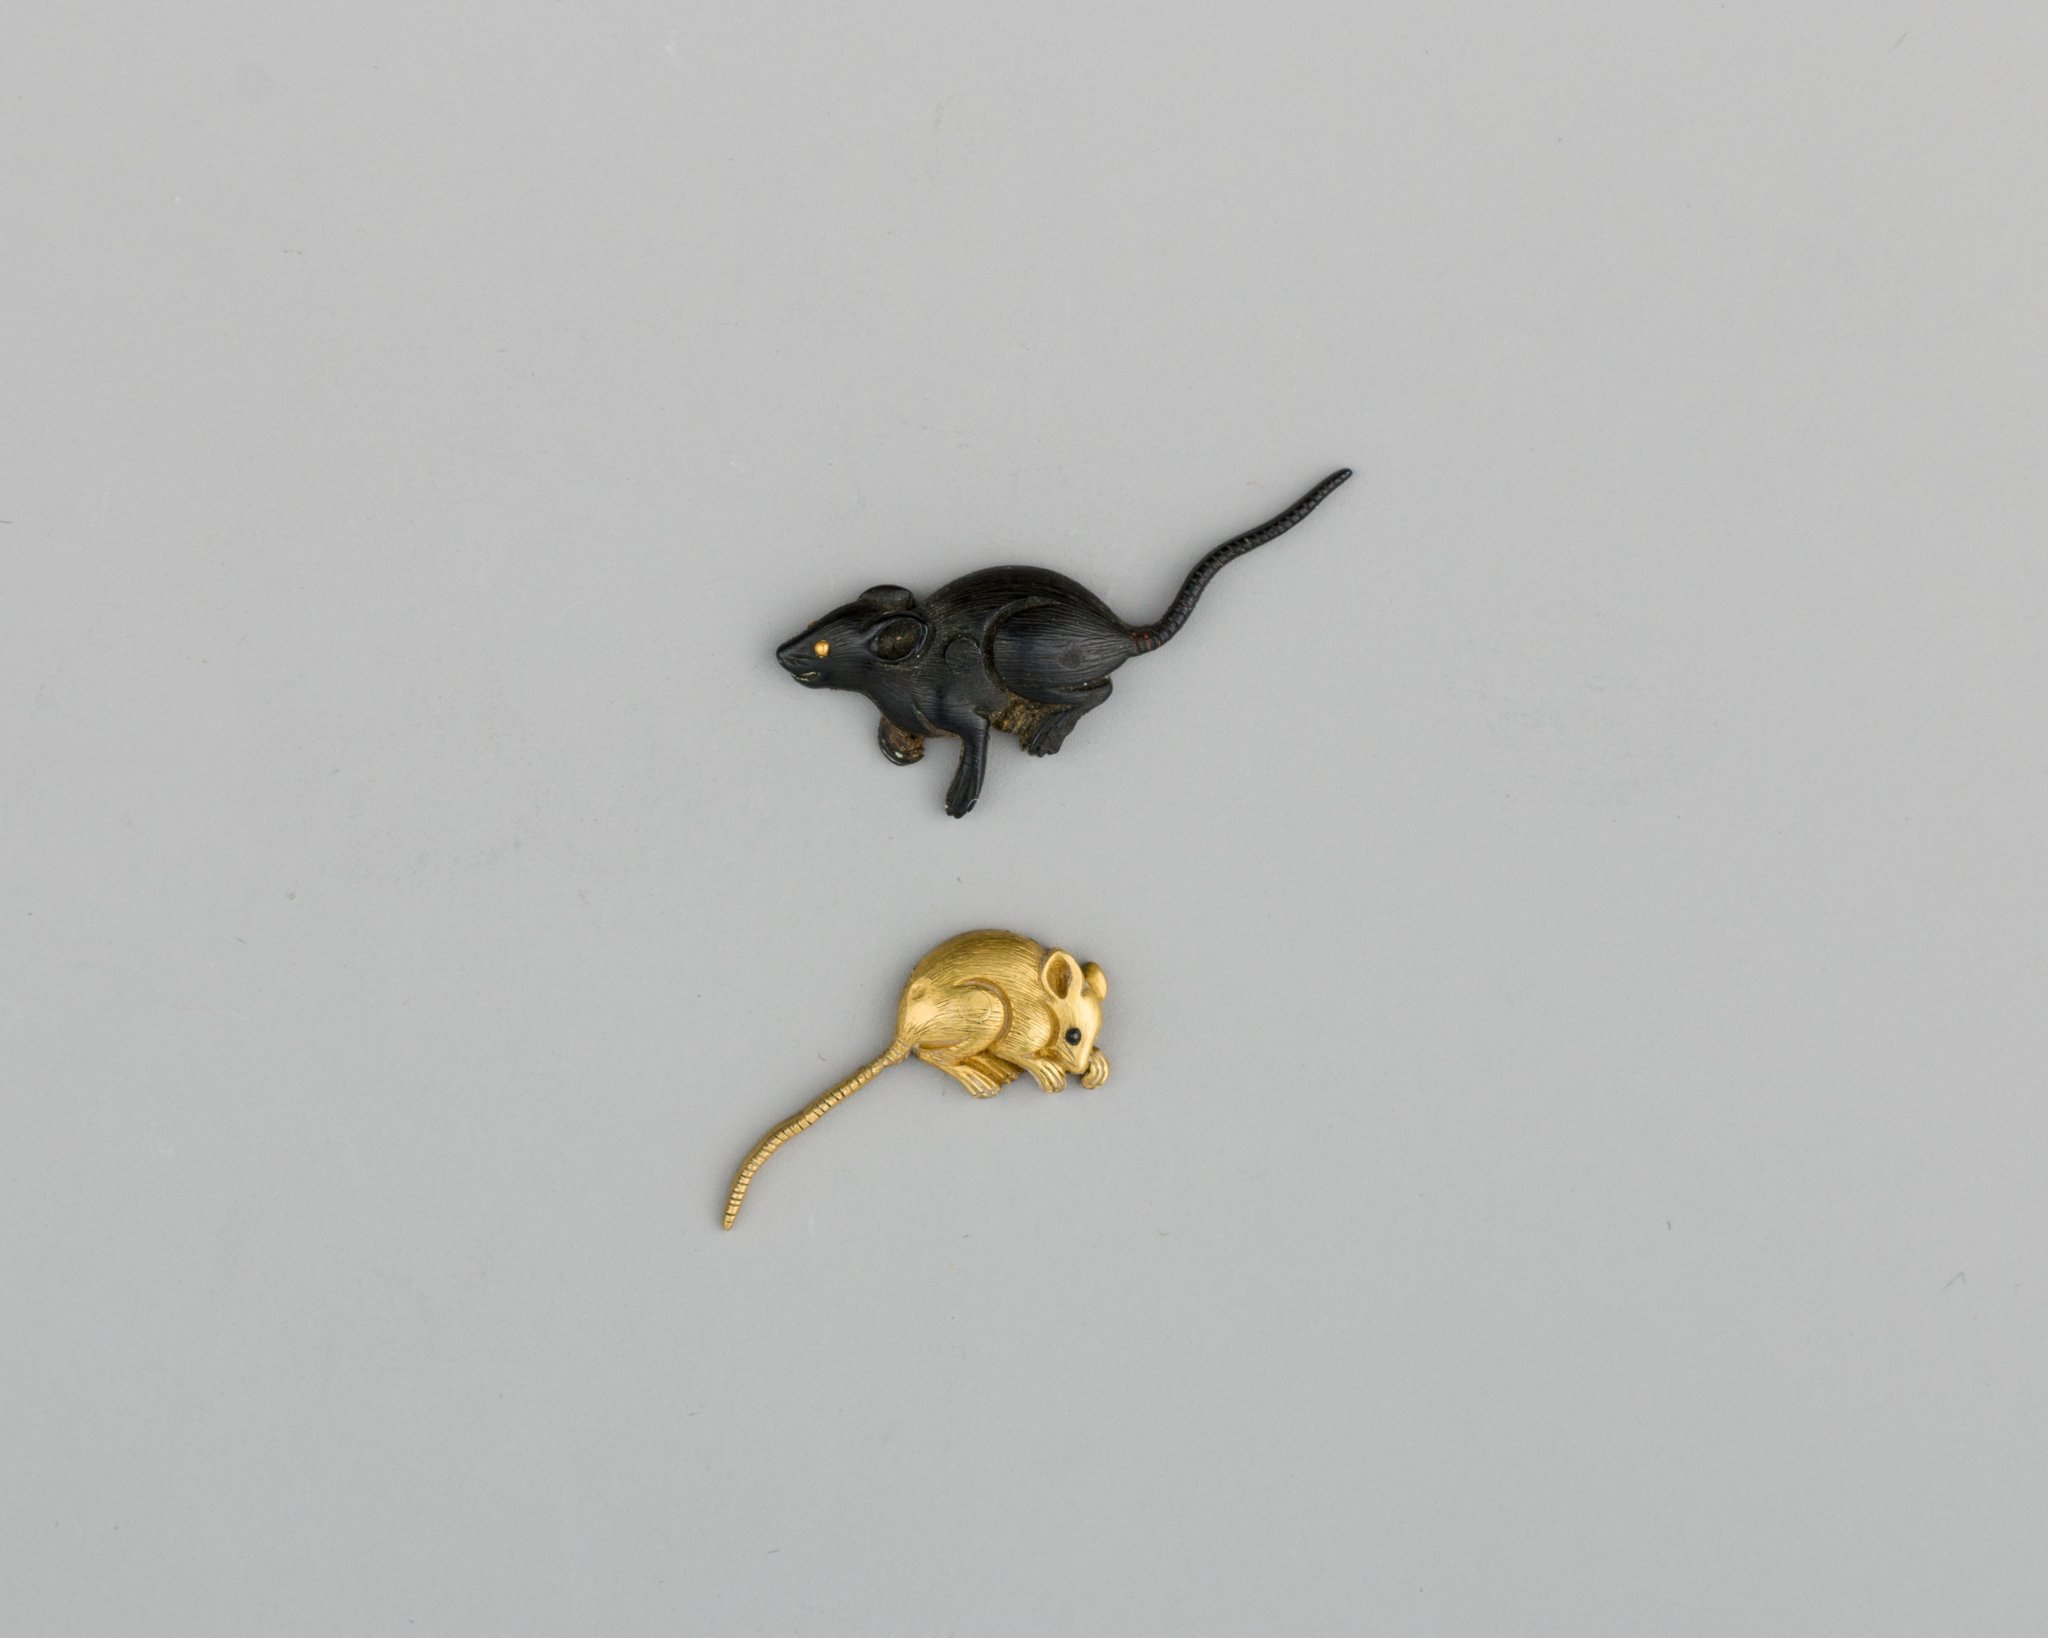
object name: pair of sword grip ornament menuki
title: Pair of Sword-Grip Ornaments (Menuki)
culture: japanese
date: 1701-1800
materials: gold alloy, gold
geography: japan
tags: mice